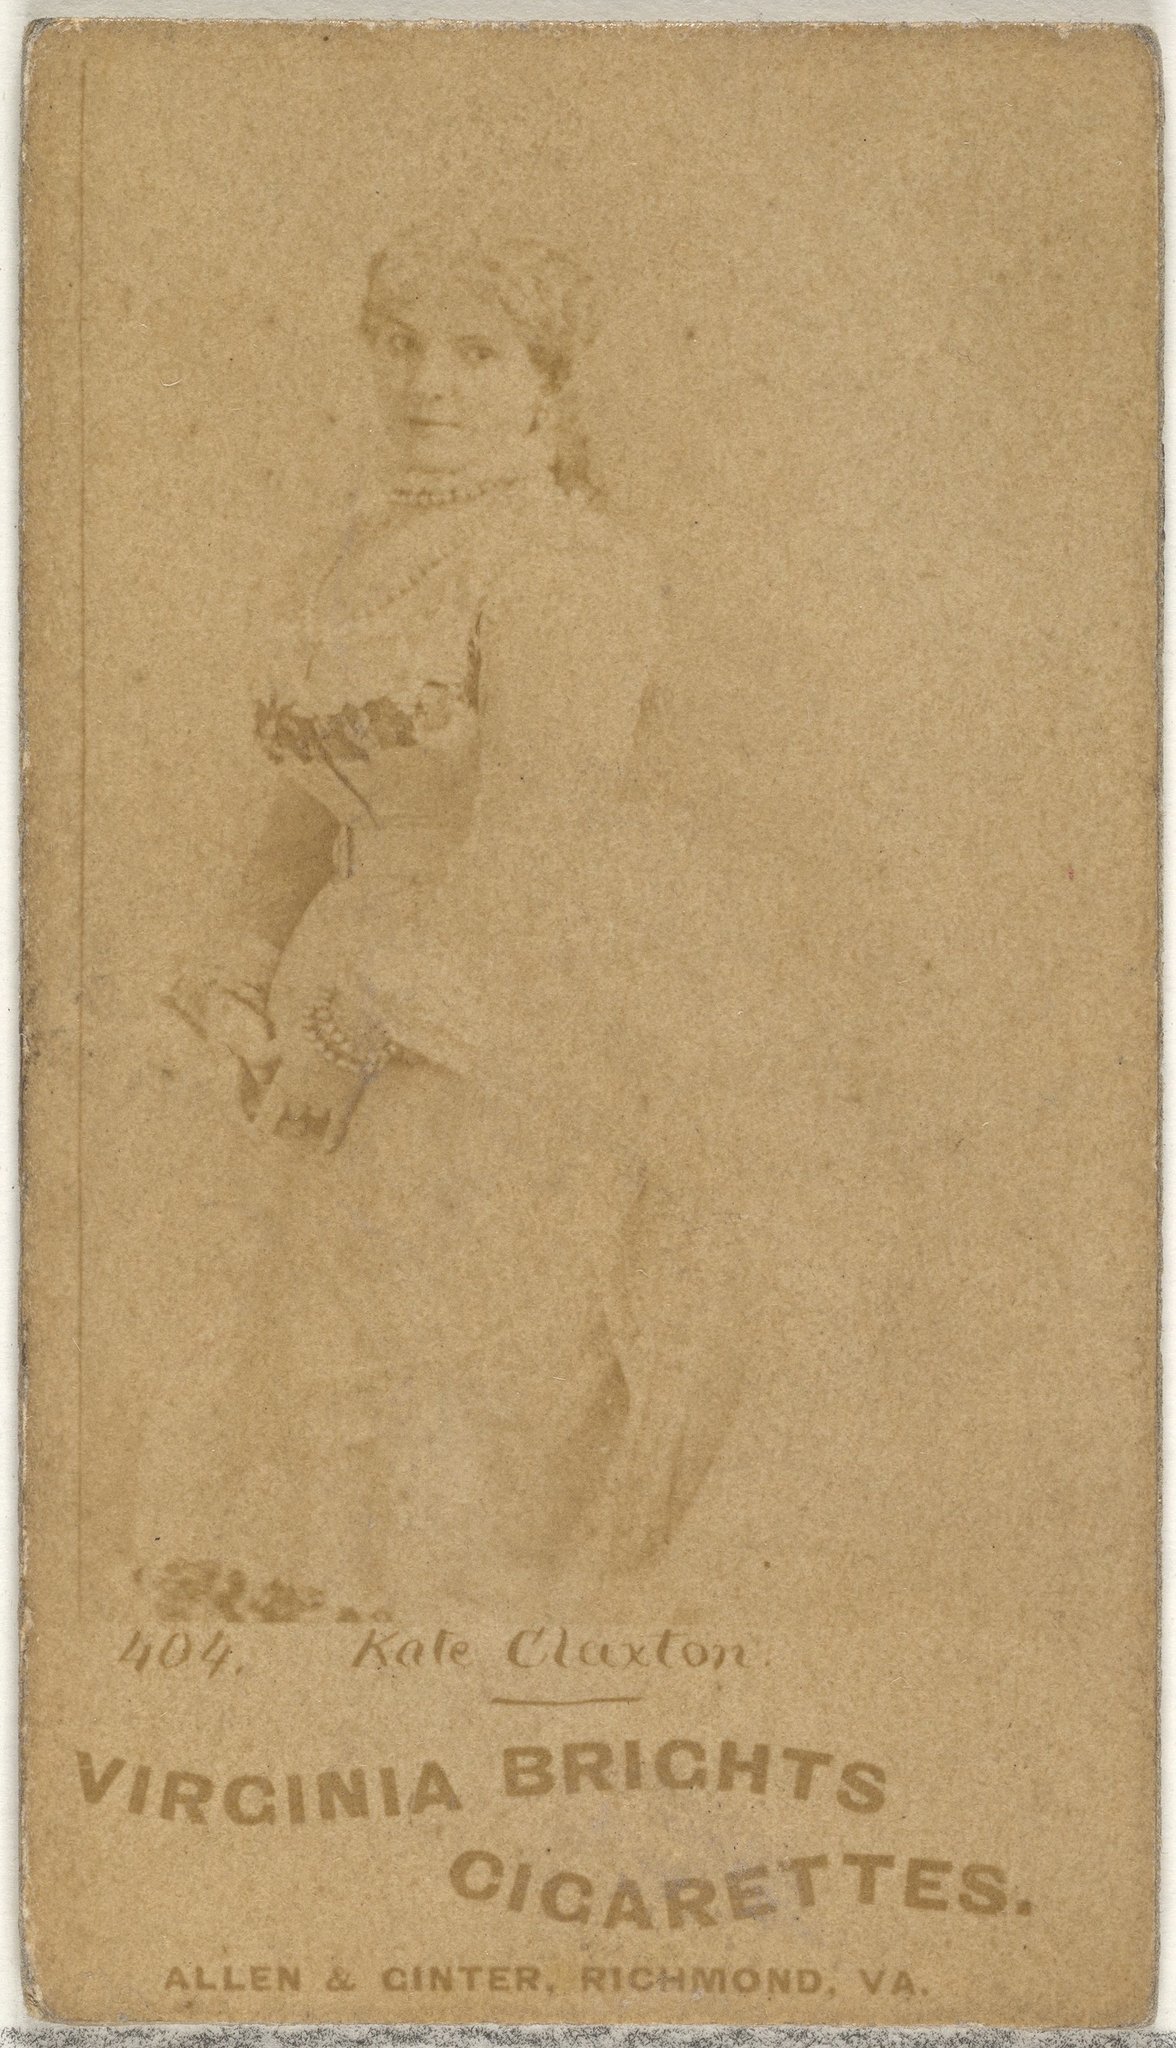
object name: photograph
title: Card 404, Kate Claxton, from the Actors and Actresses series (N45, Type 1) for Virginia Brights Cigarettes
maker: allen & ginter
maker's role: publisher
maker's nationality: american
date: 1888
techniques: albumen silver print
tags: portraits,women,actresses